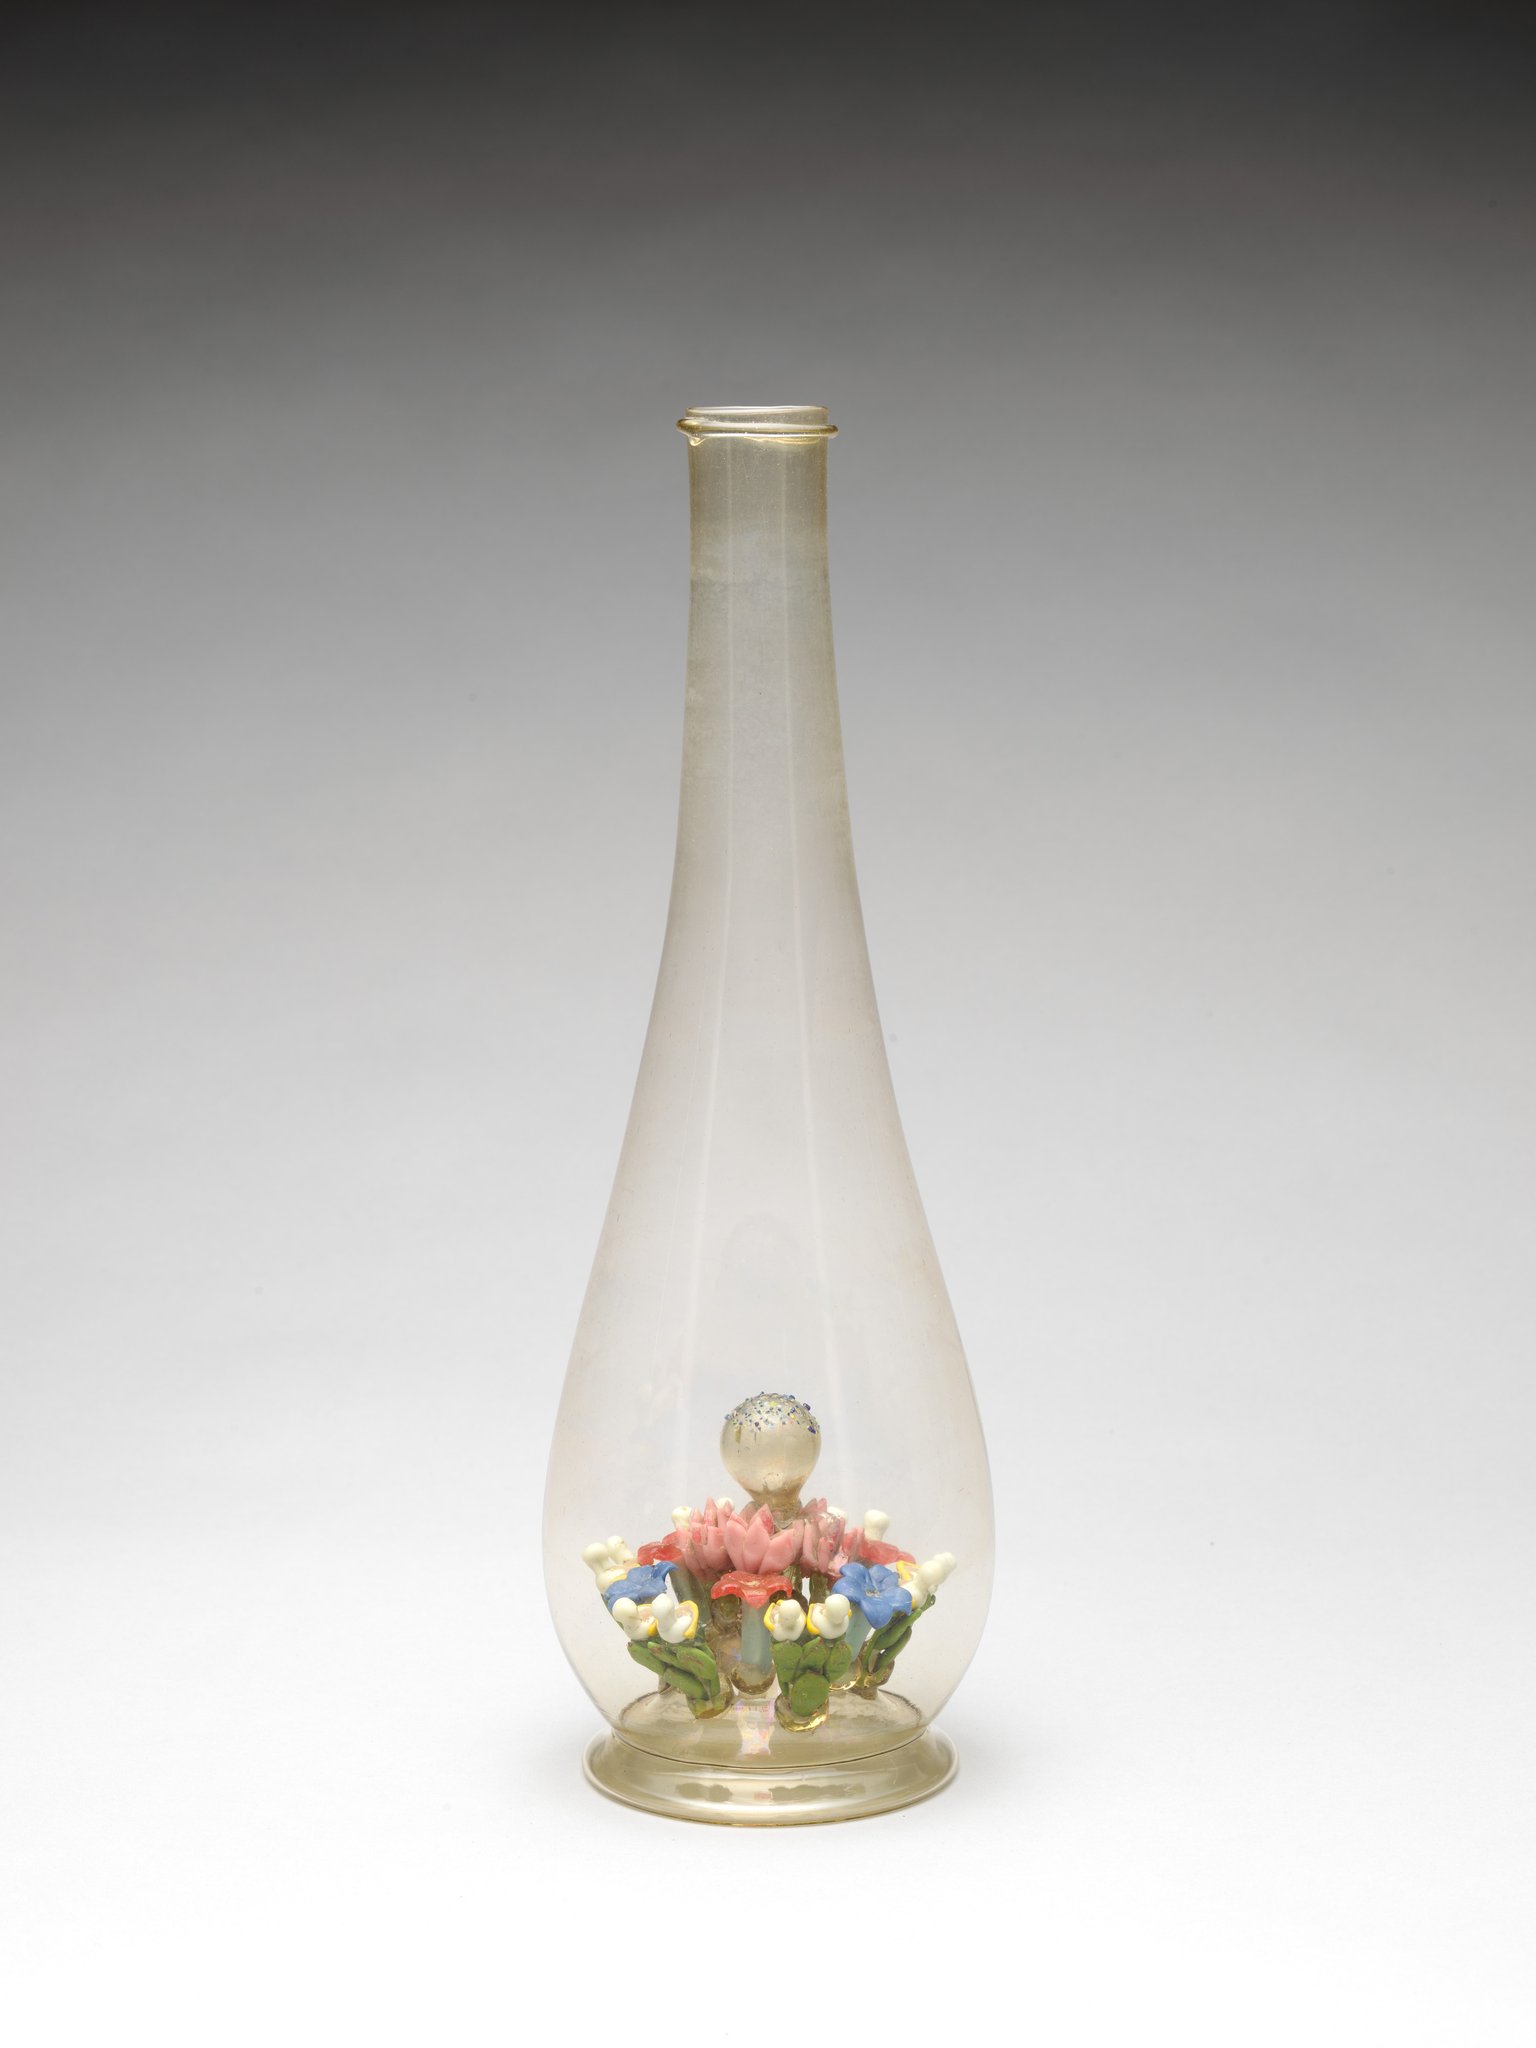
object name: water pipe base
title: Water Pipe Base (Qalian)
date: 1701-1900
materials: glass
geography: iran